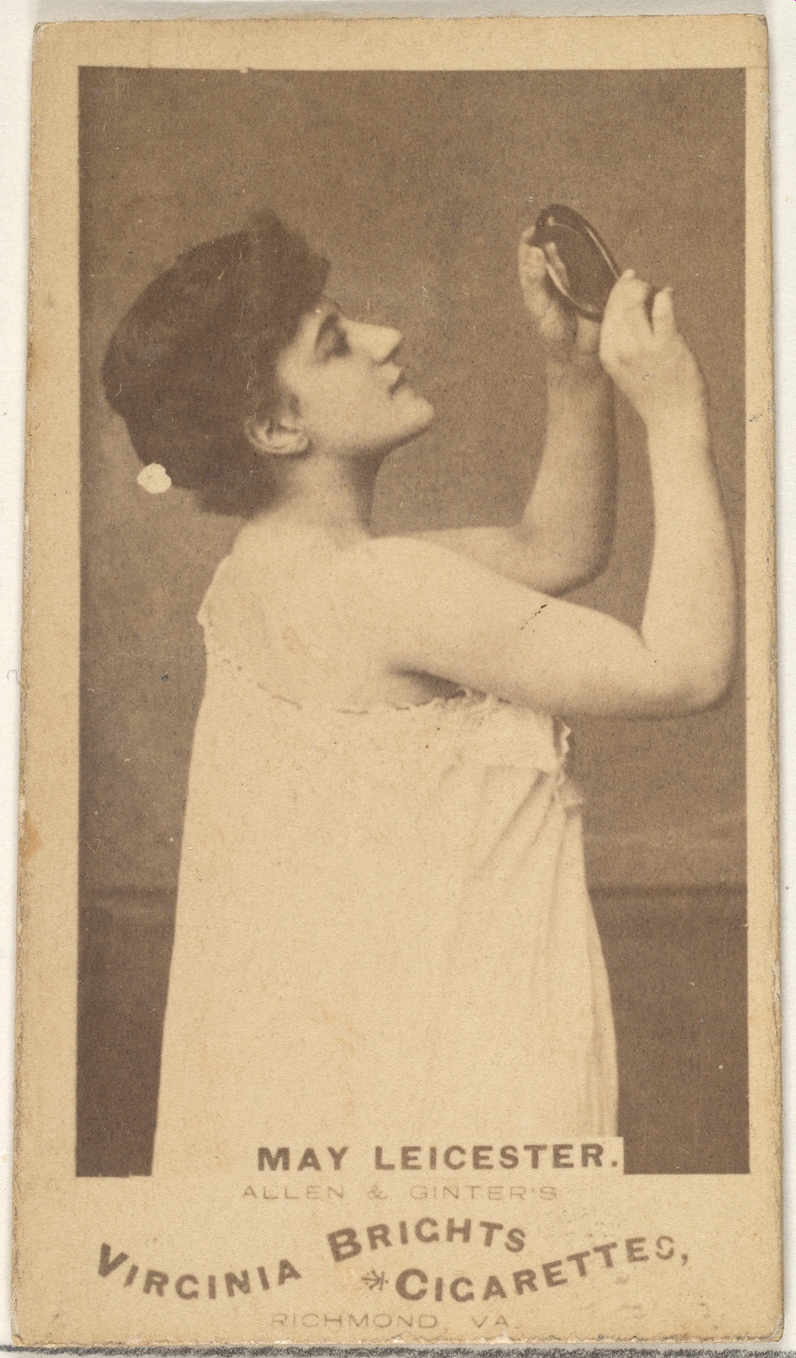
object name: photograph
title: May Leicester, from the Actors and Actresses series (N45, Type 1) for Virginia Brights Cigarettes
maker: allen & ginter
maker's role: publisher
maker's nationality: american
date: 1888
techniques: albumen silver print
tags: portraits,profiles,women,actresses,mirrors